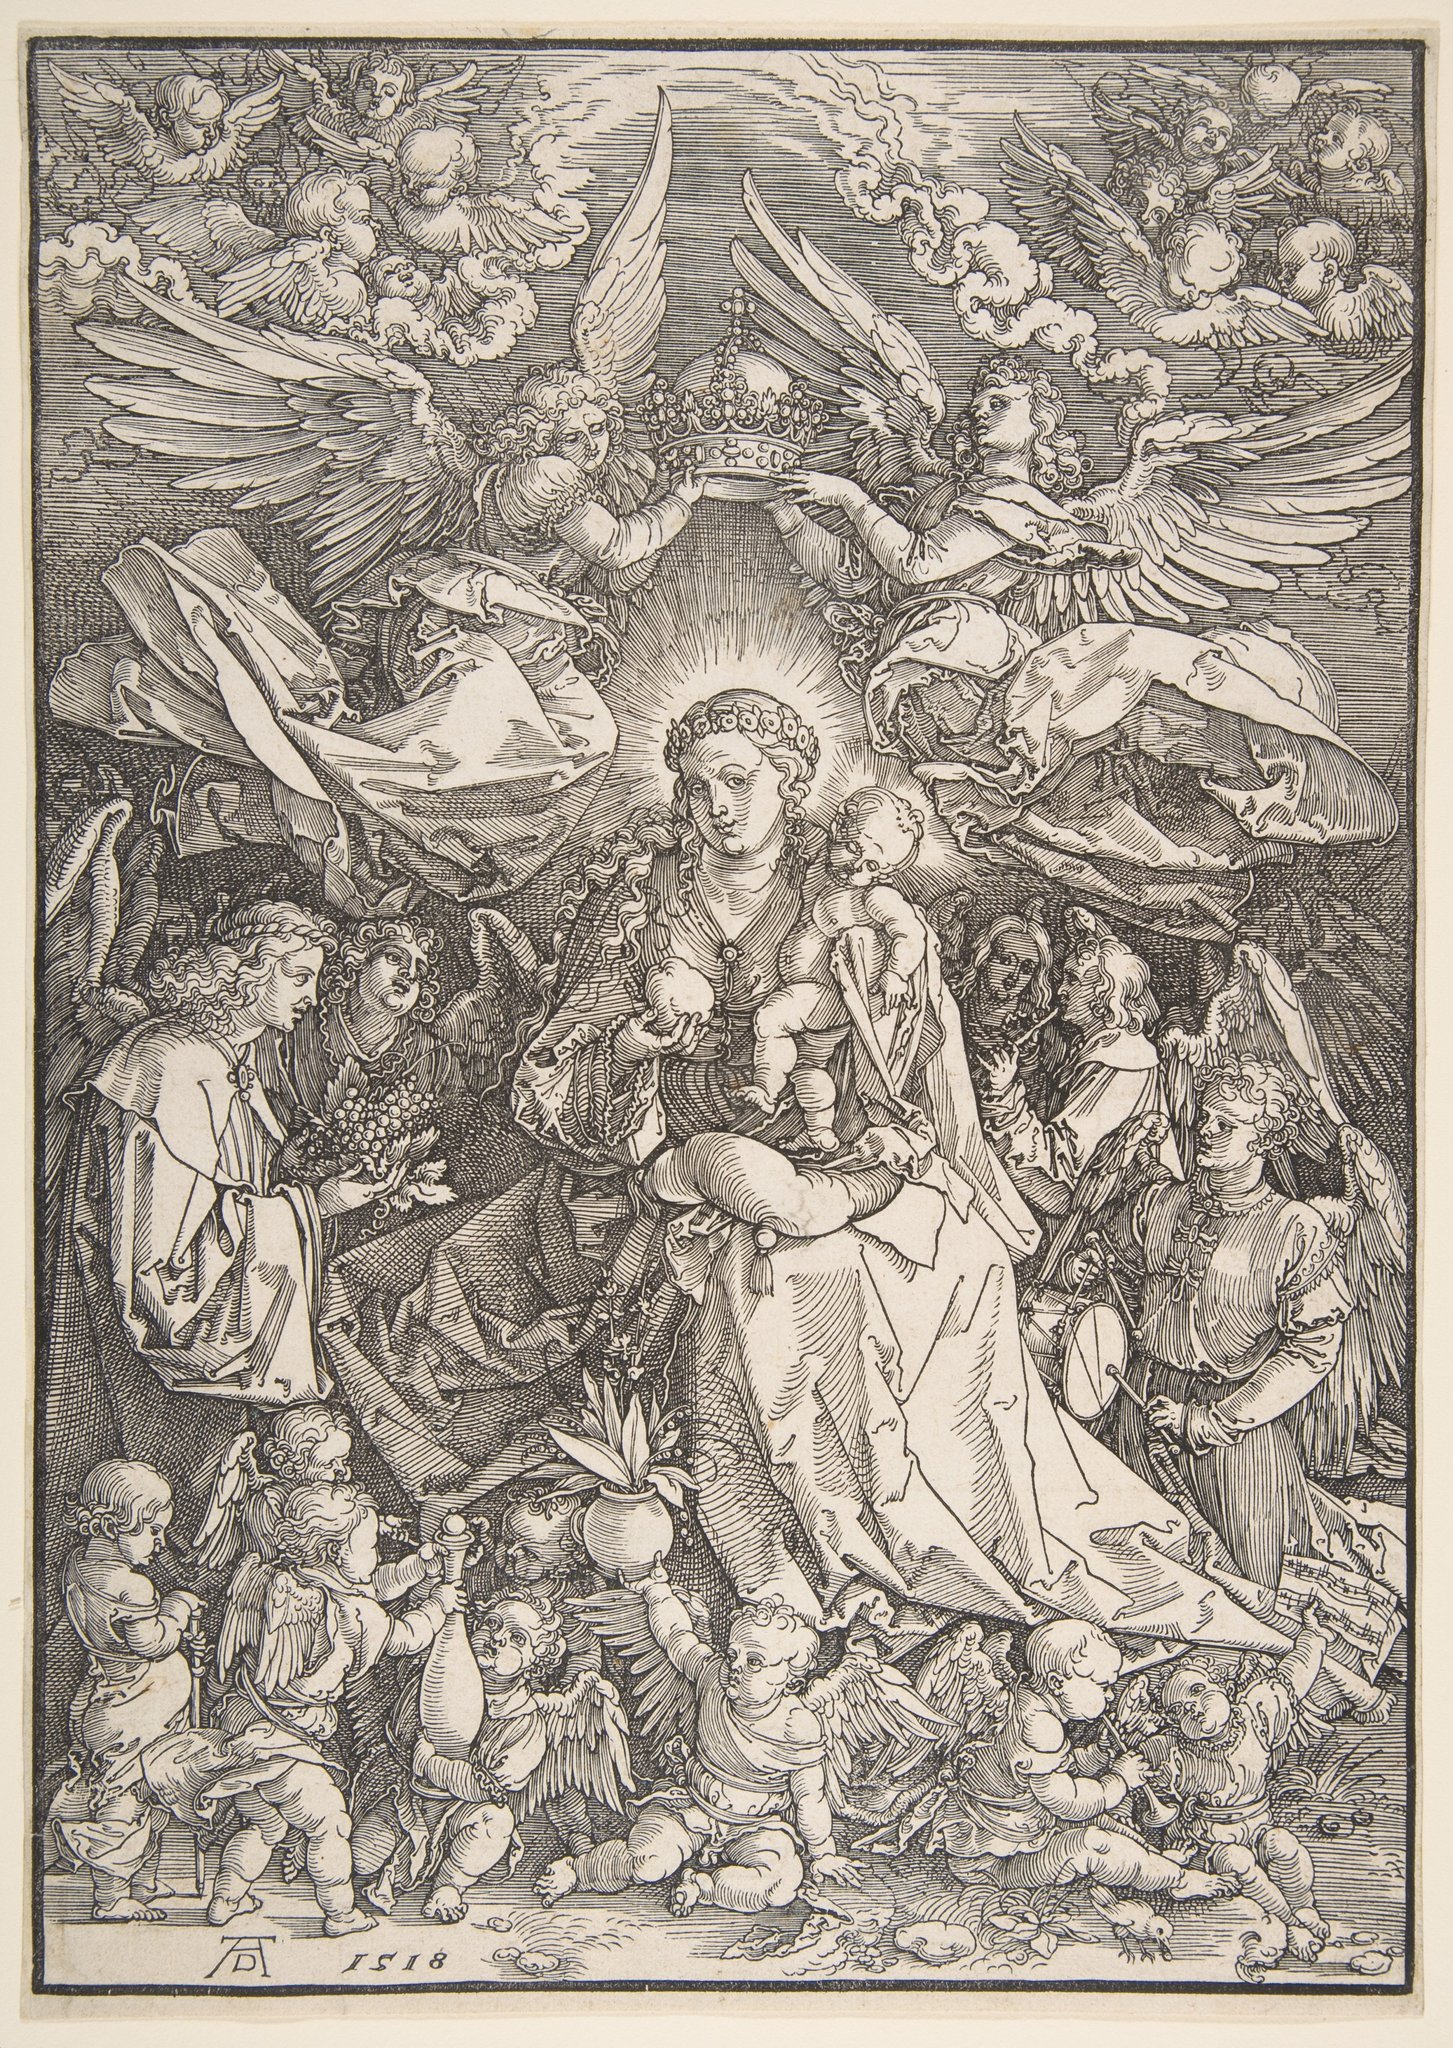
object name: print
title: The Virgin Surrounded by Many Angels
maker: albrecht dürer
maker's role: artist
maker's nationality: german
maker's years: 1471-1528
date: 1518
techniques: woodcut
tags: angels,madonna and child